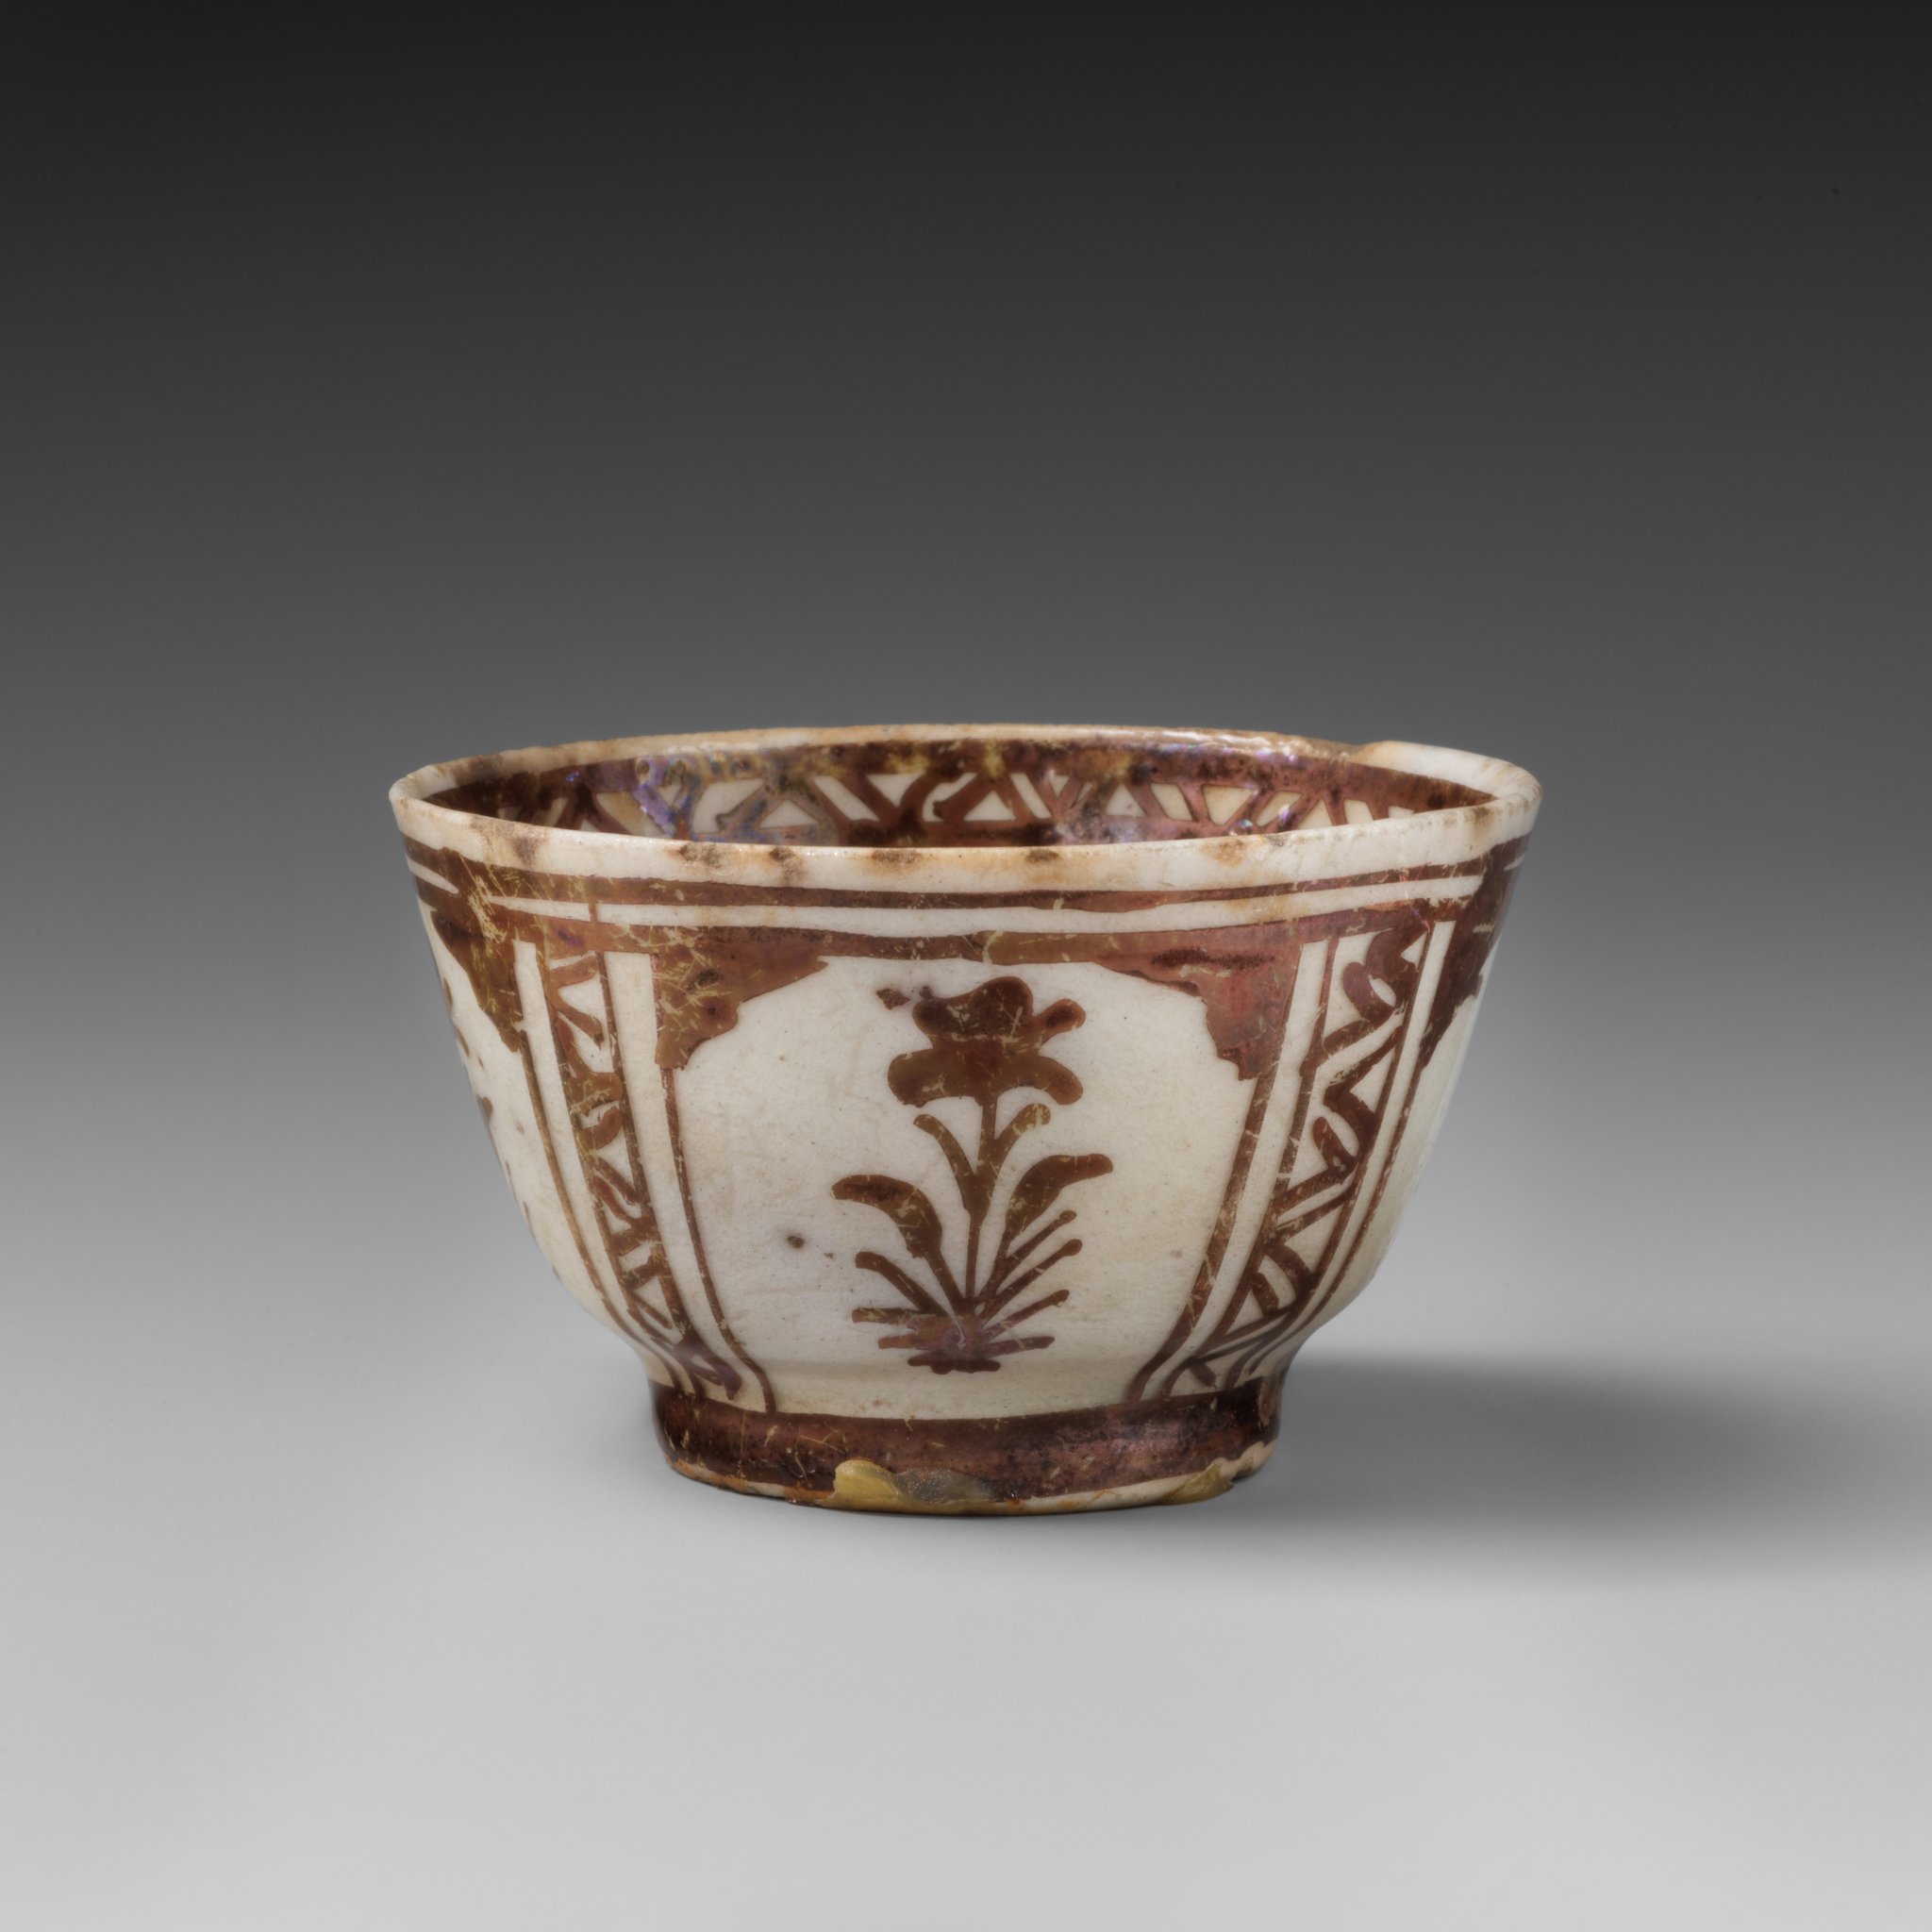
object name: cup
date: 1601-1700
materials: glaze, stonepaste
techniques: luster painting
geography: iran